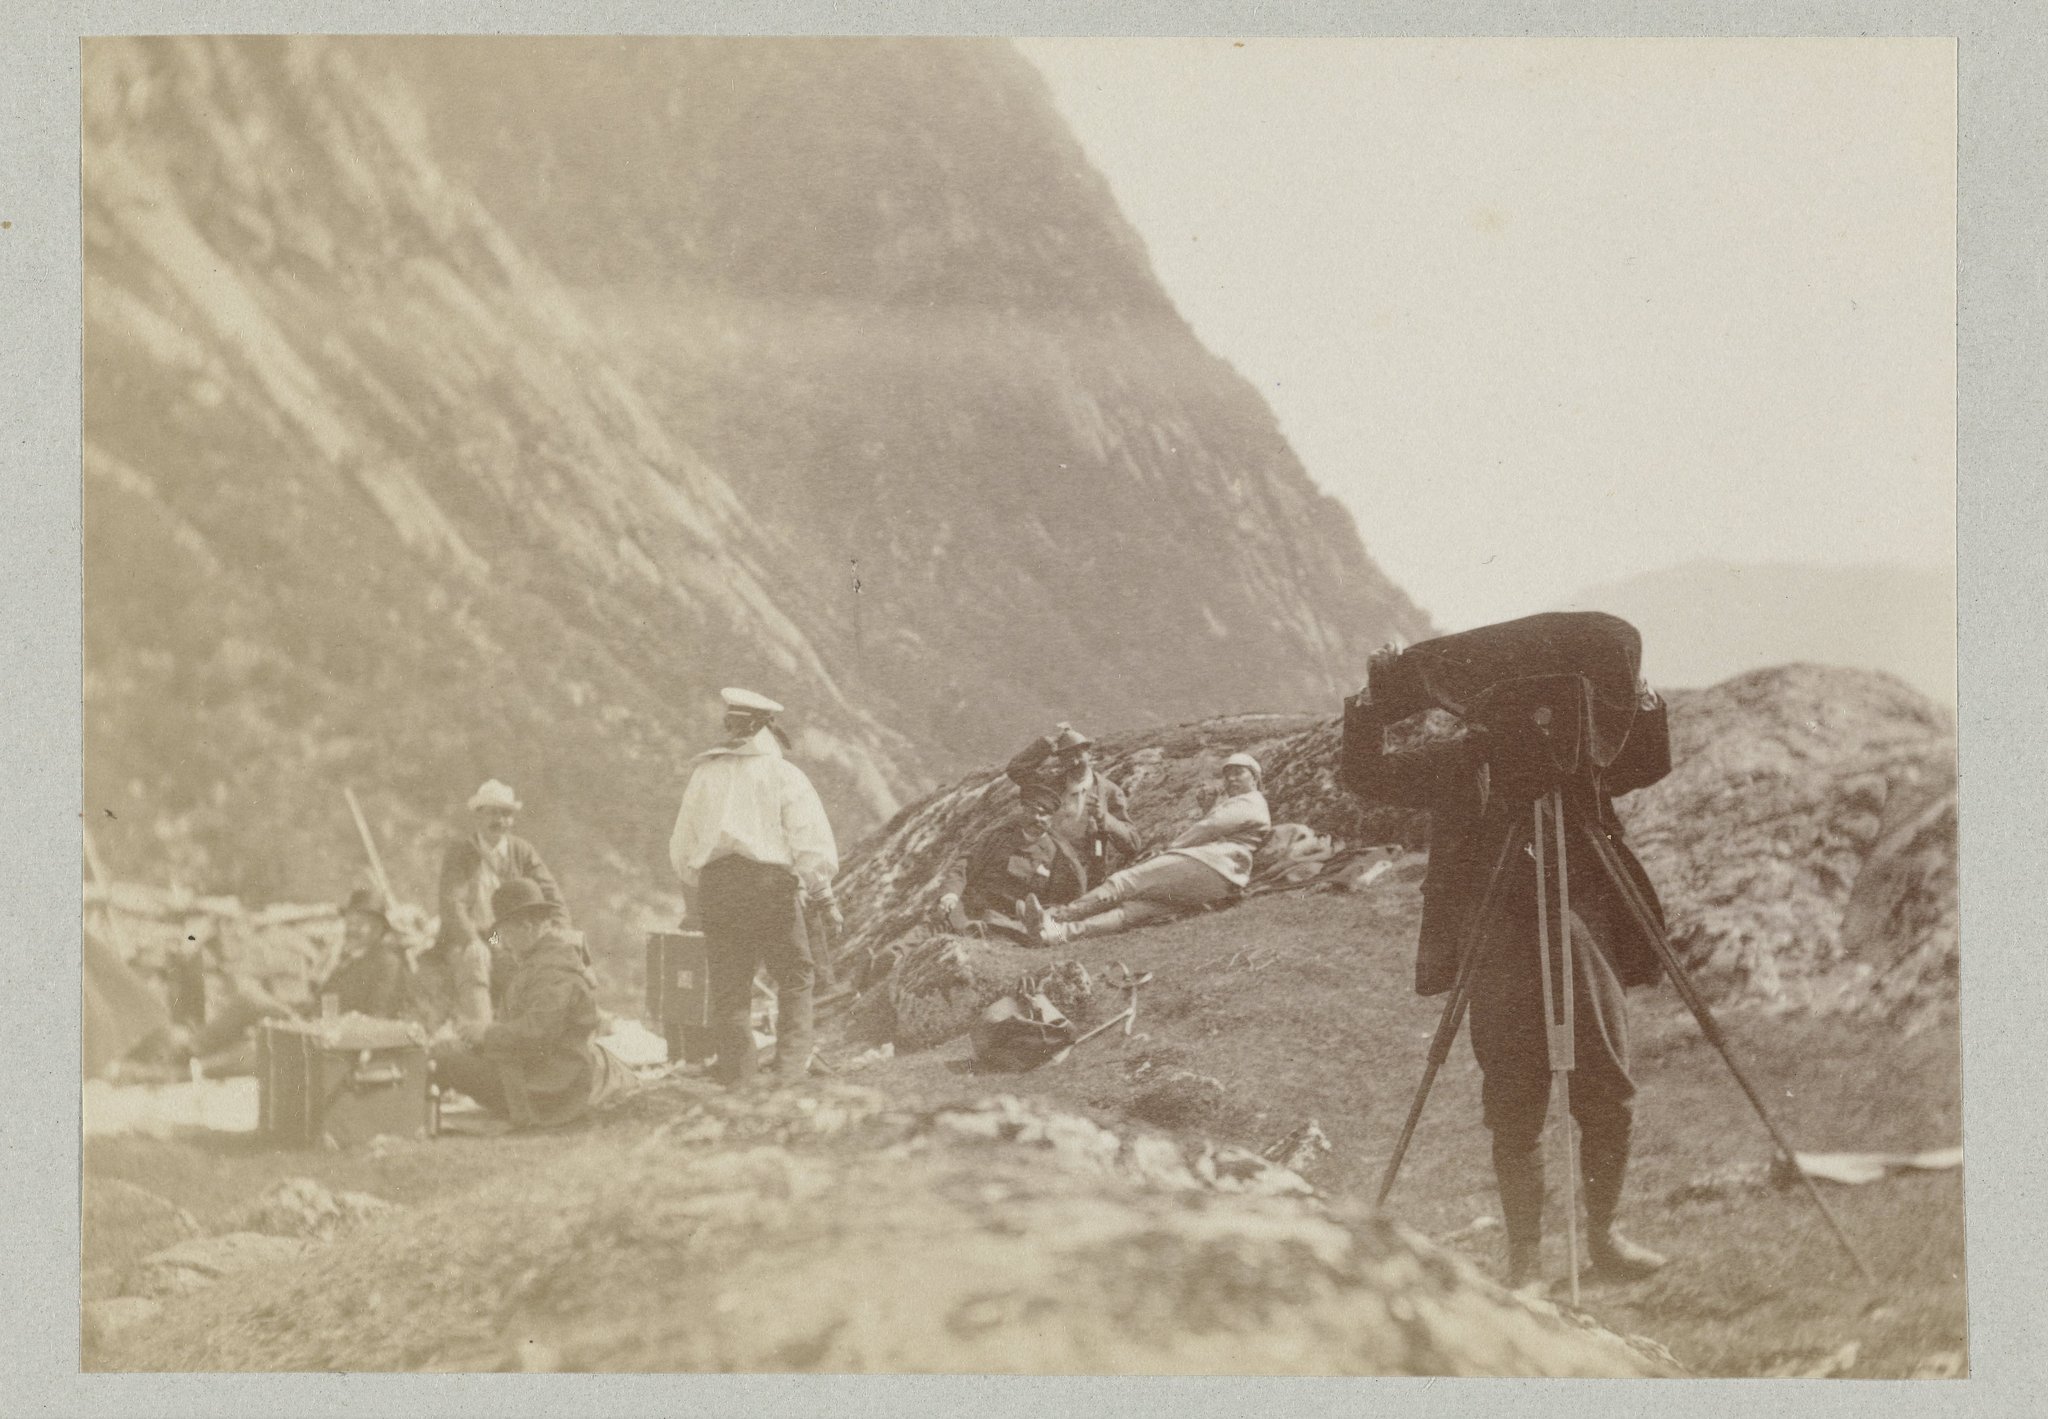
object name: photograph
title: Partie nach dem Buarbrae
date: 1807-1889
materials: cardboard, paper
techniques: albumen print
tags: wilhelm ii (keizer van duitsland), norway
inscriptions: number: ‘6’